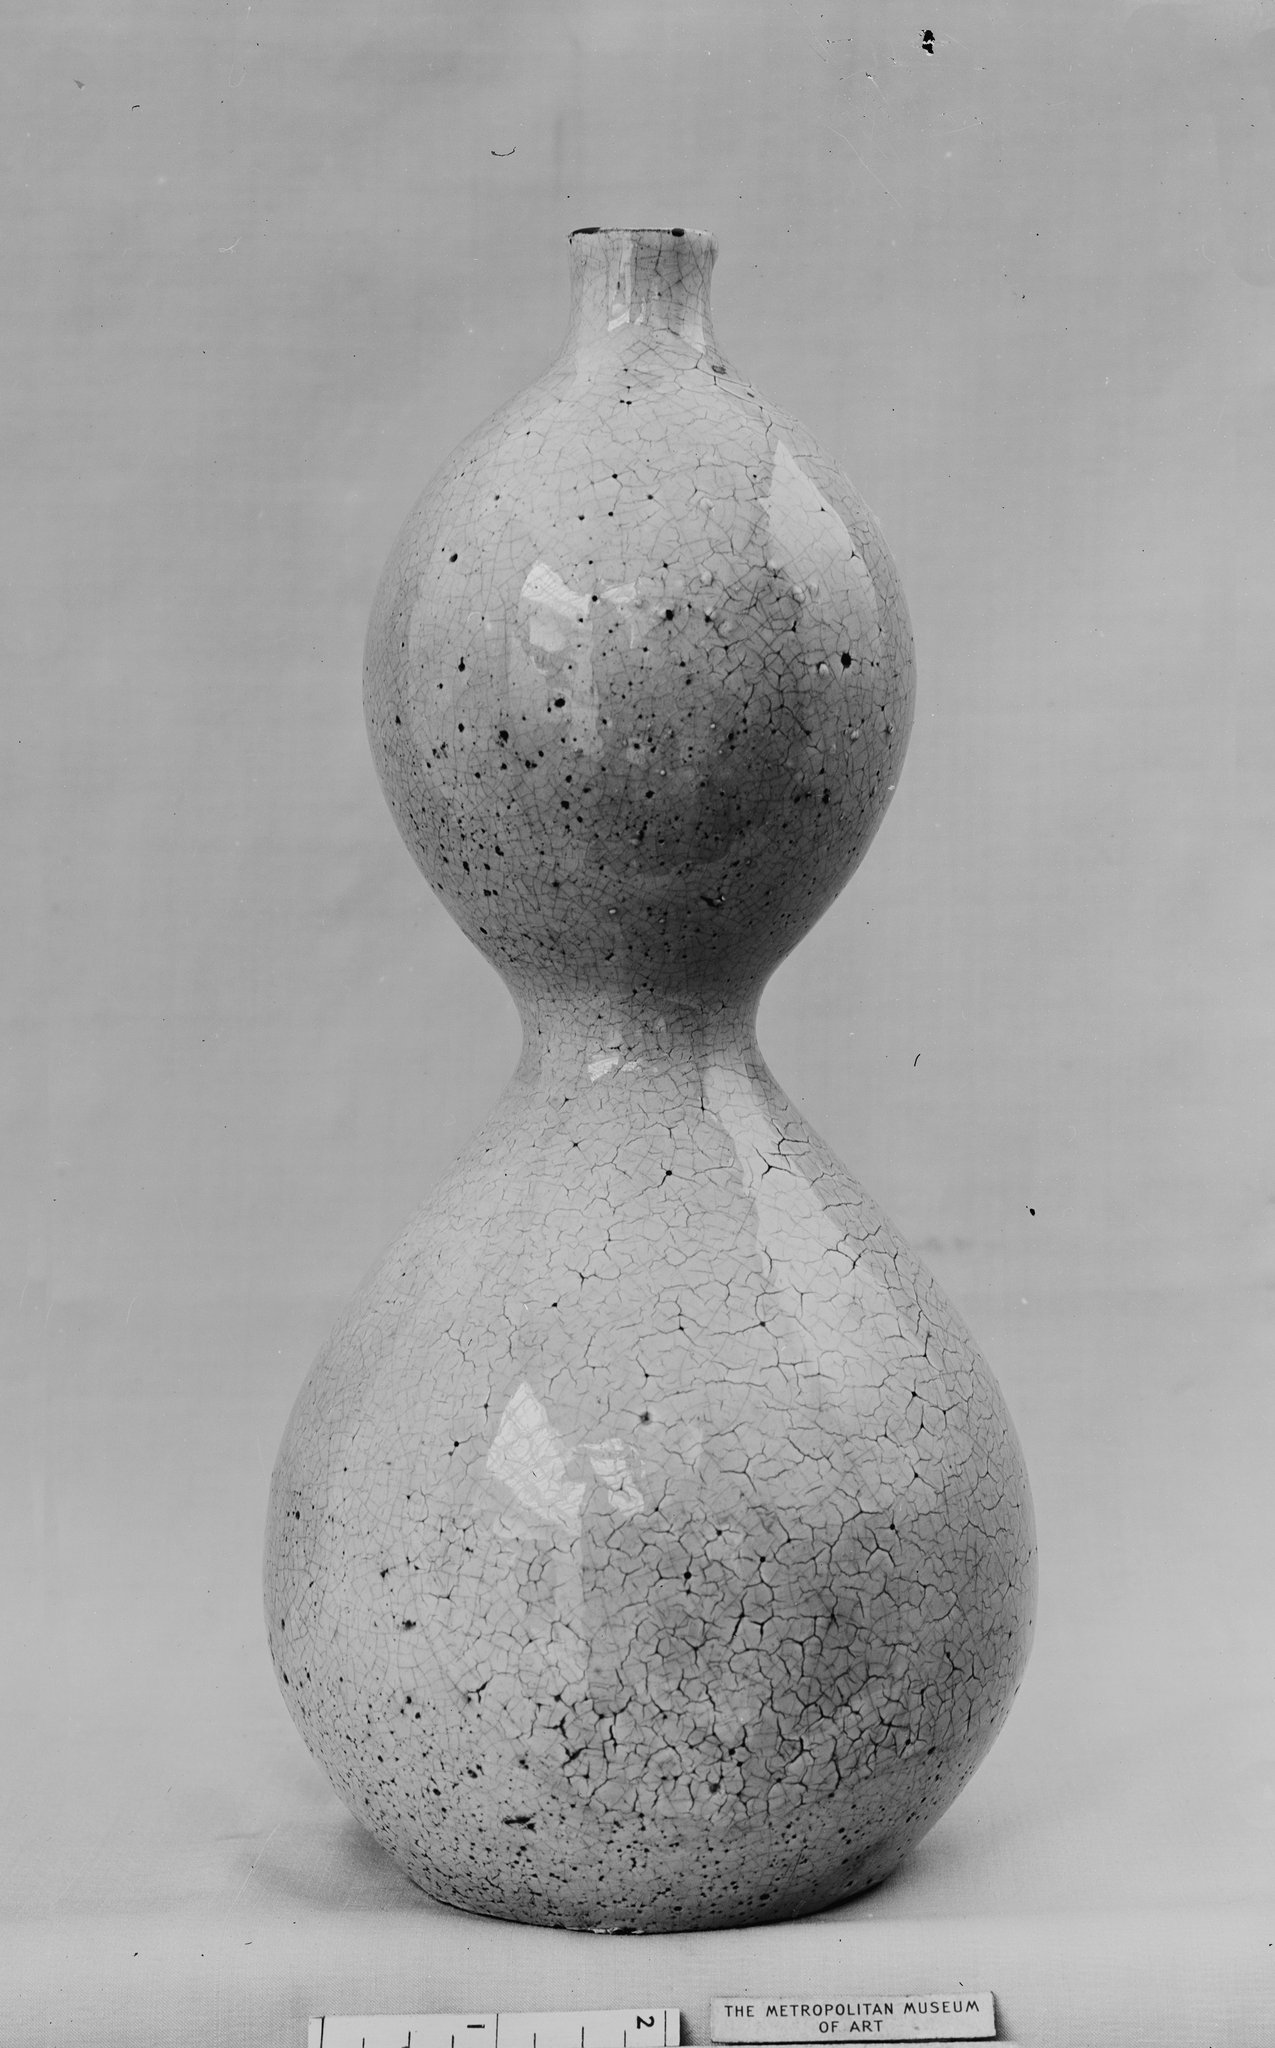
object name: bottle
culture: japanese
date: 1701-1800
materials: clay, glaze